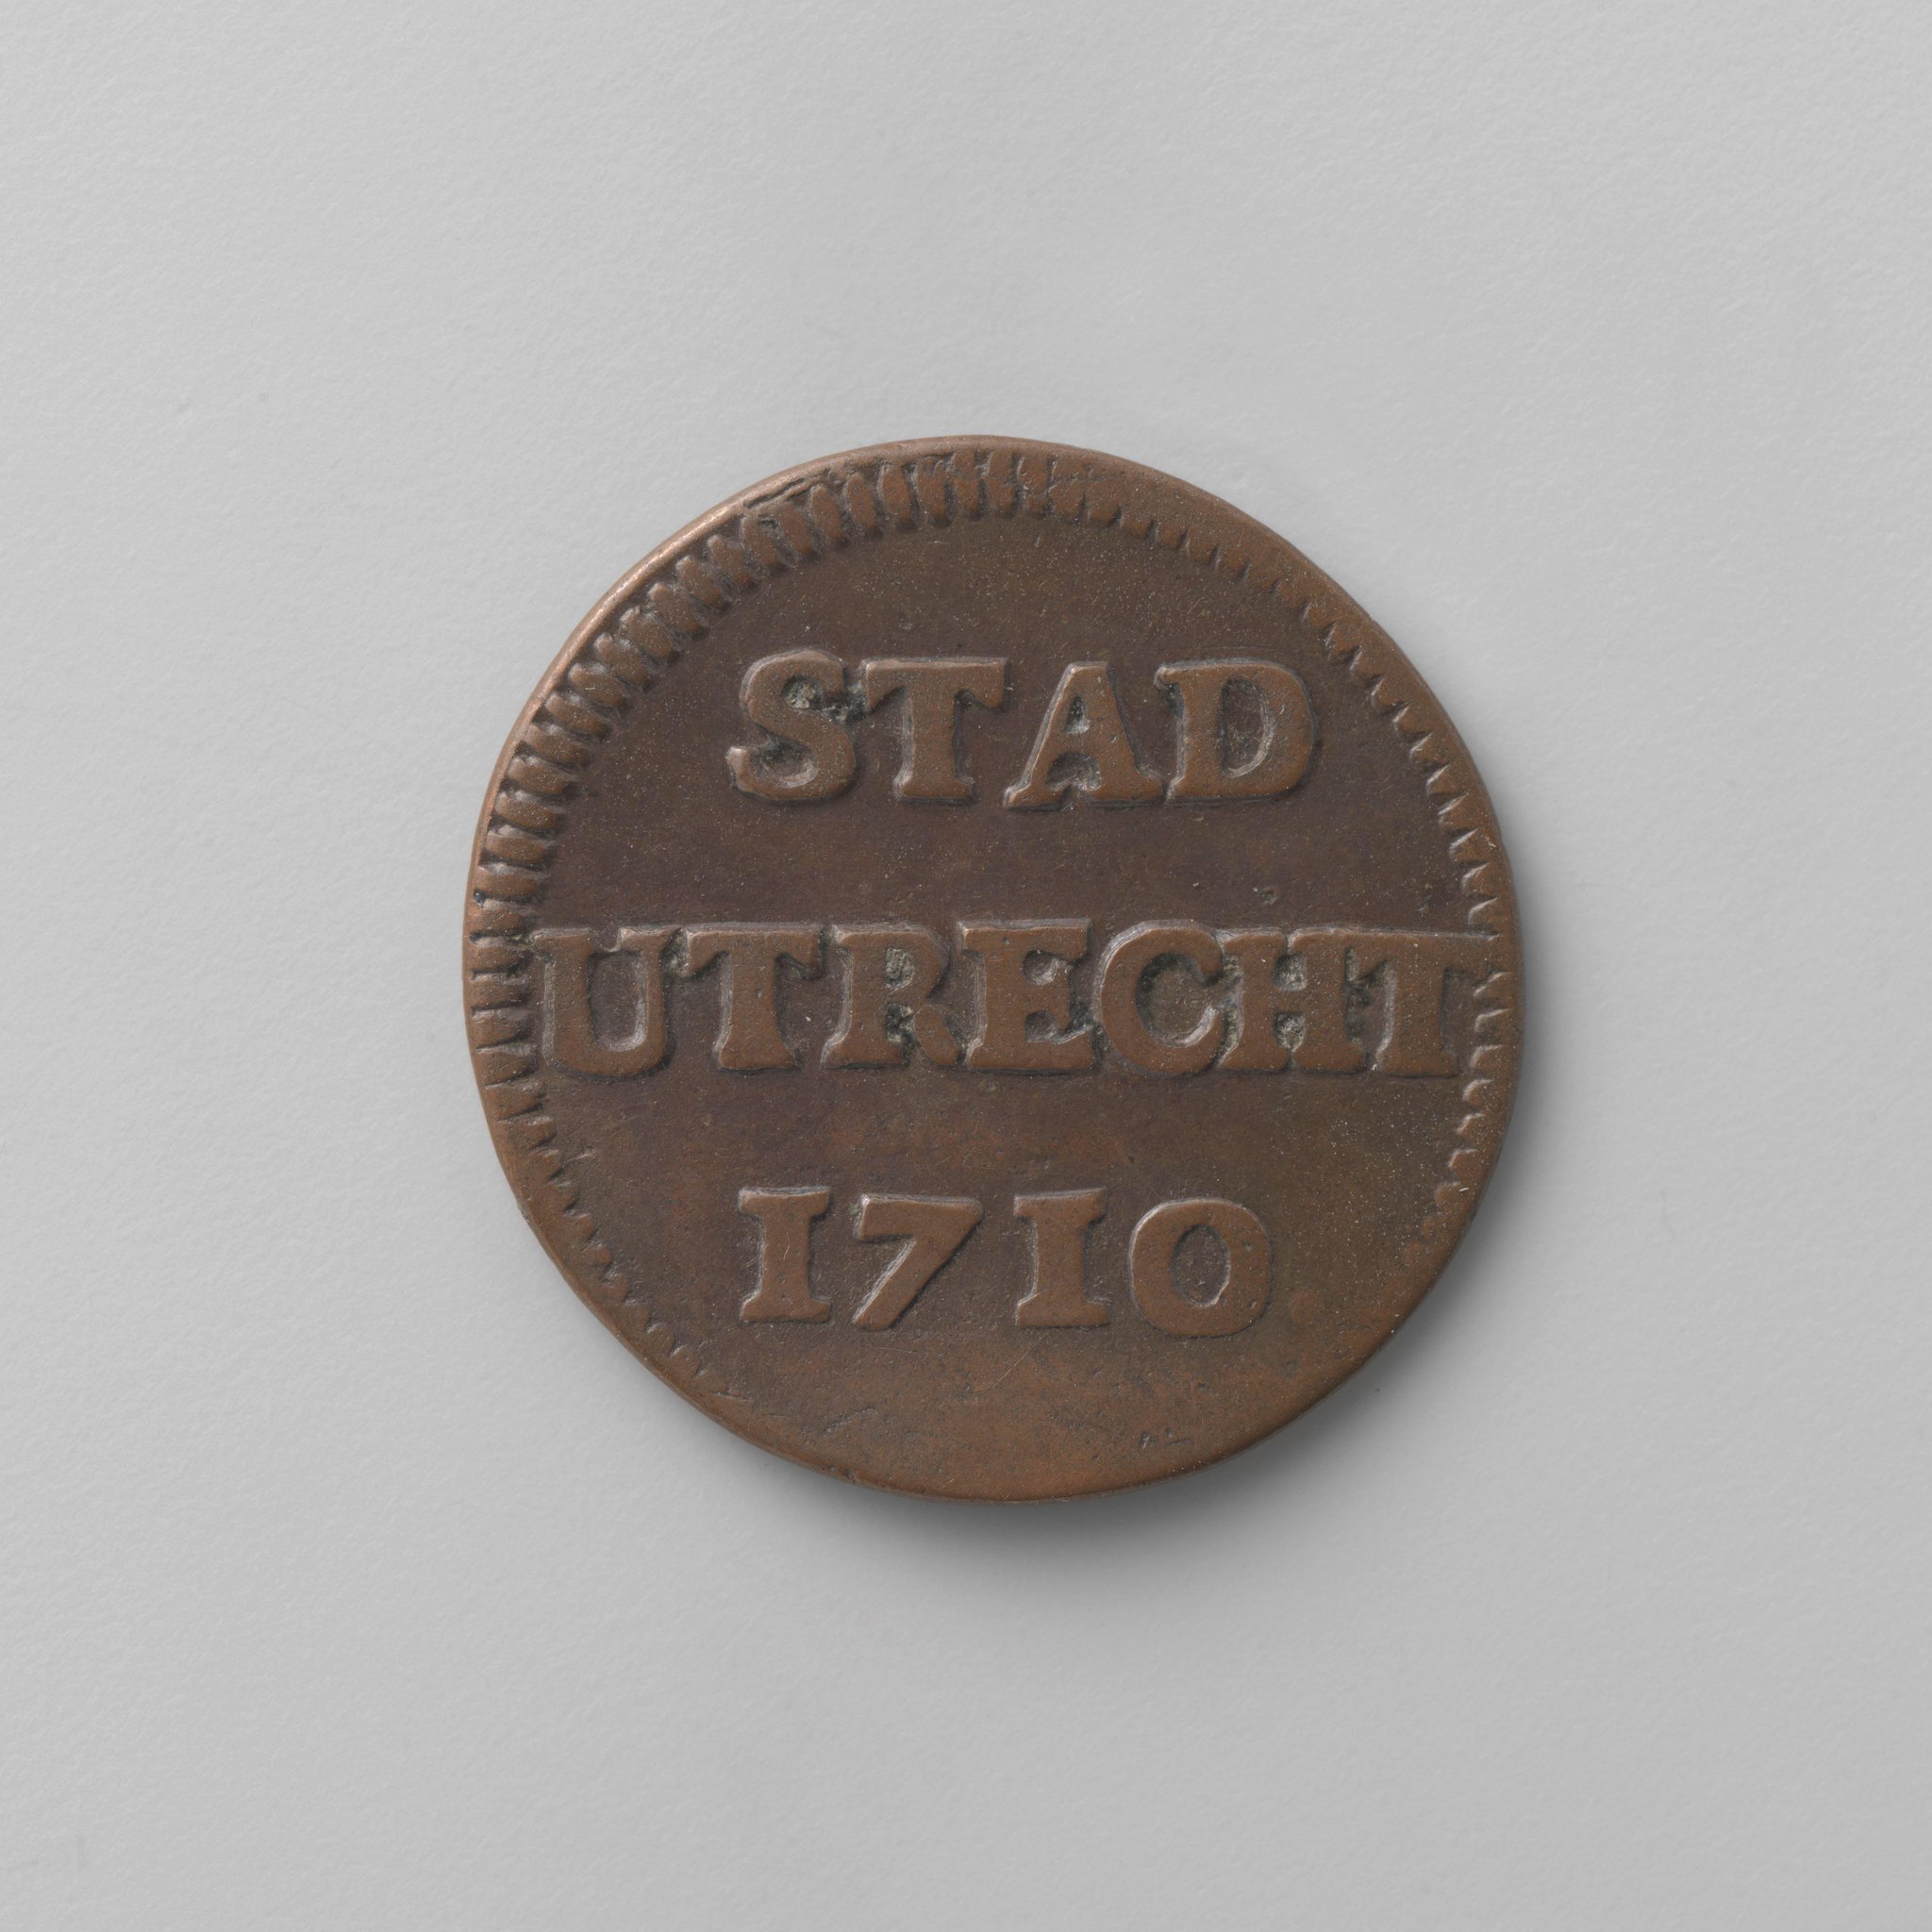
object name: coin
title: Duit van de stad Utrecht, 1710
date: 1710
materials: copper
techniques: striking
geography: utrecht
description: Koperen munt. Voorzijde: gekroond stedelijk wapenschild. Keerzijde: opschrift in twee regels, waaronder jaartal.